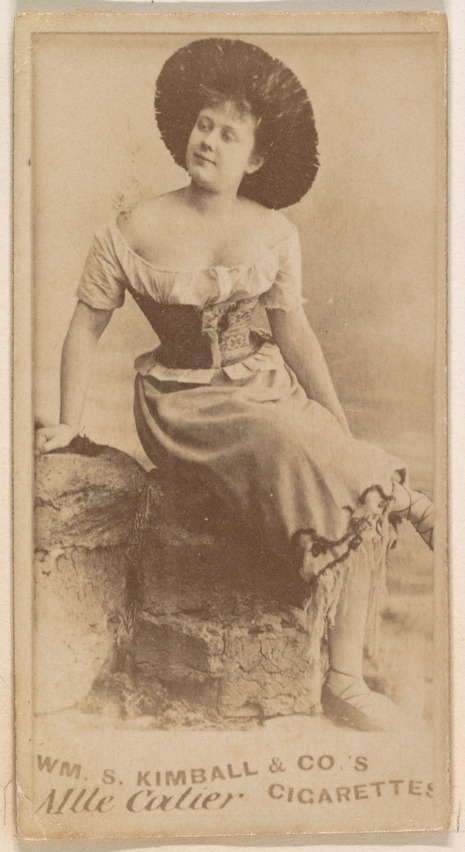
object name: photograph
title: Mlle. Calier, from the Actresses series (N203) issued by Wm. S. Kimball & Co.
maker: william s. kimball & company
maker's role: publisher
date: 1889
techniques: color lithograph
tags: portraits,women,actresses